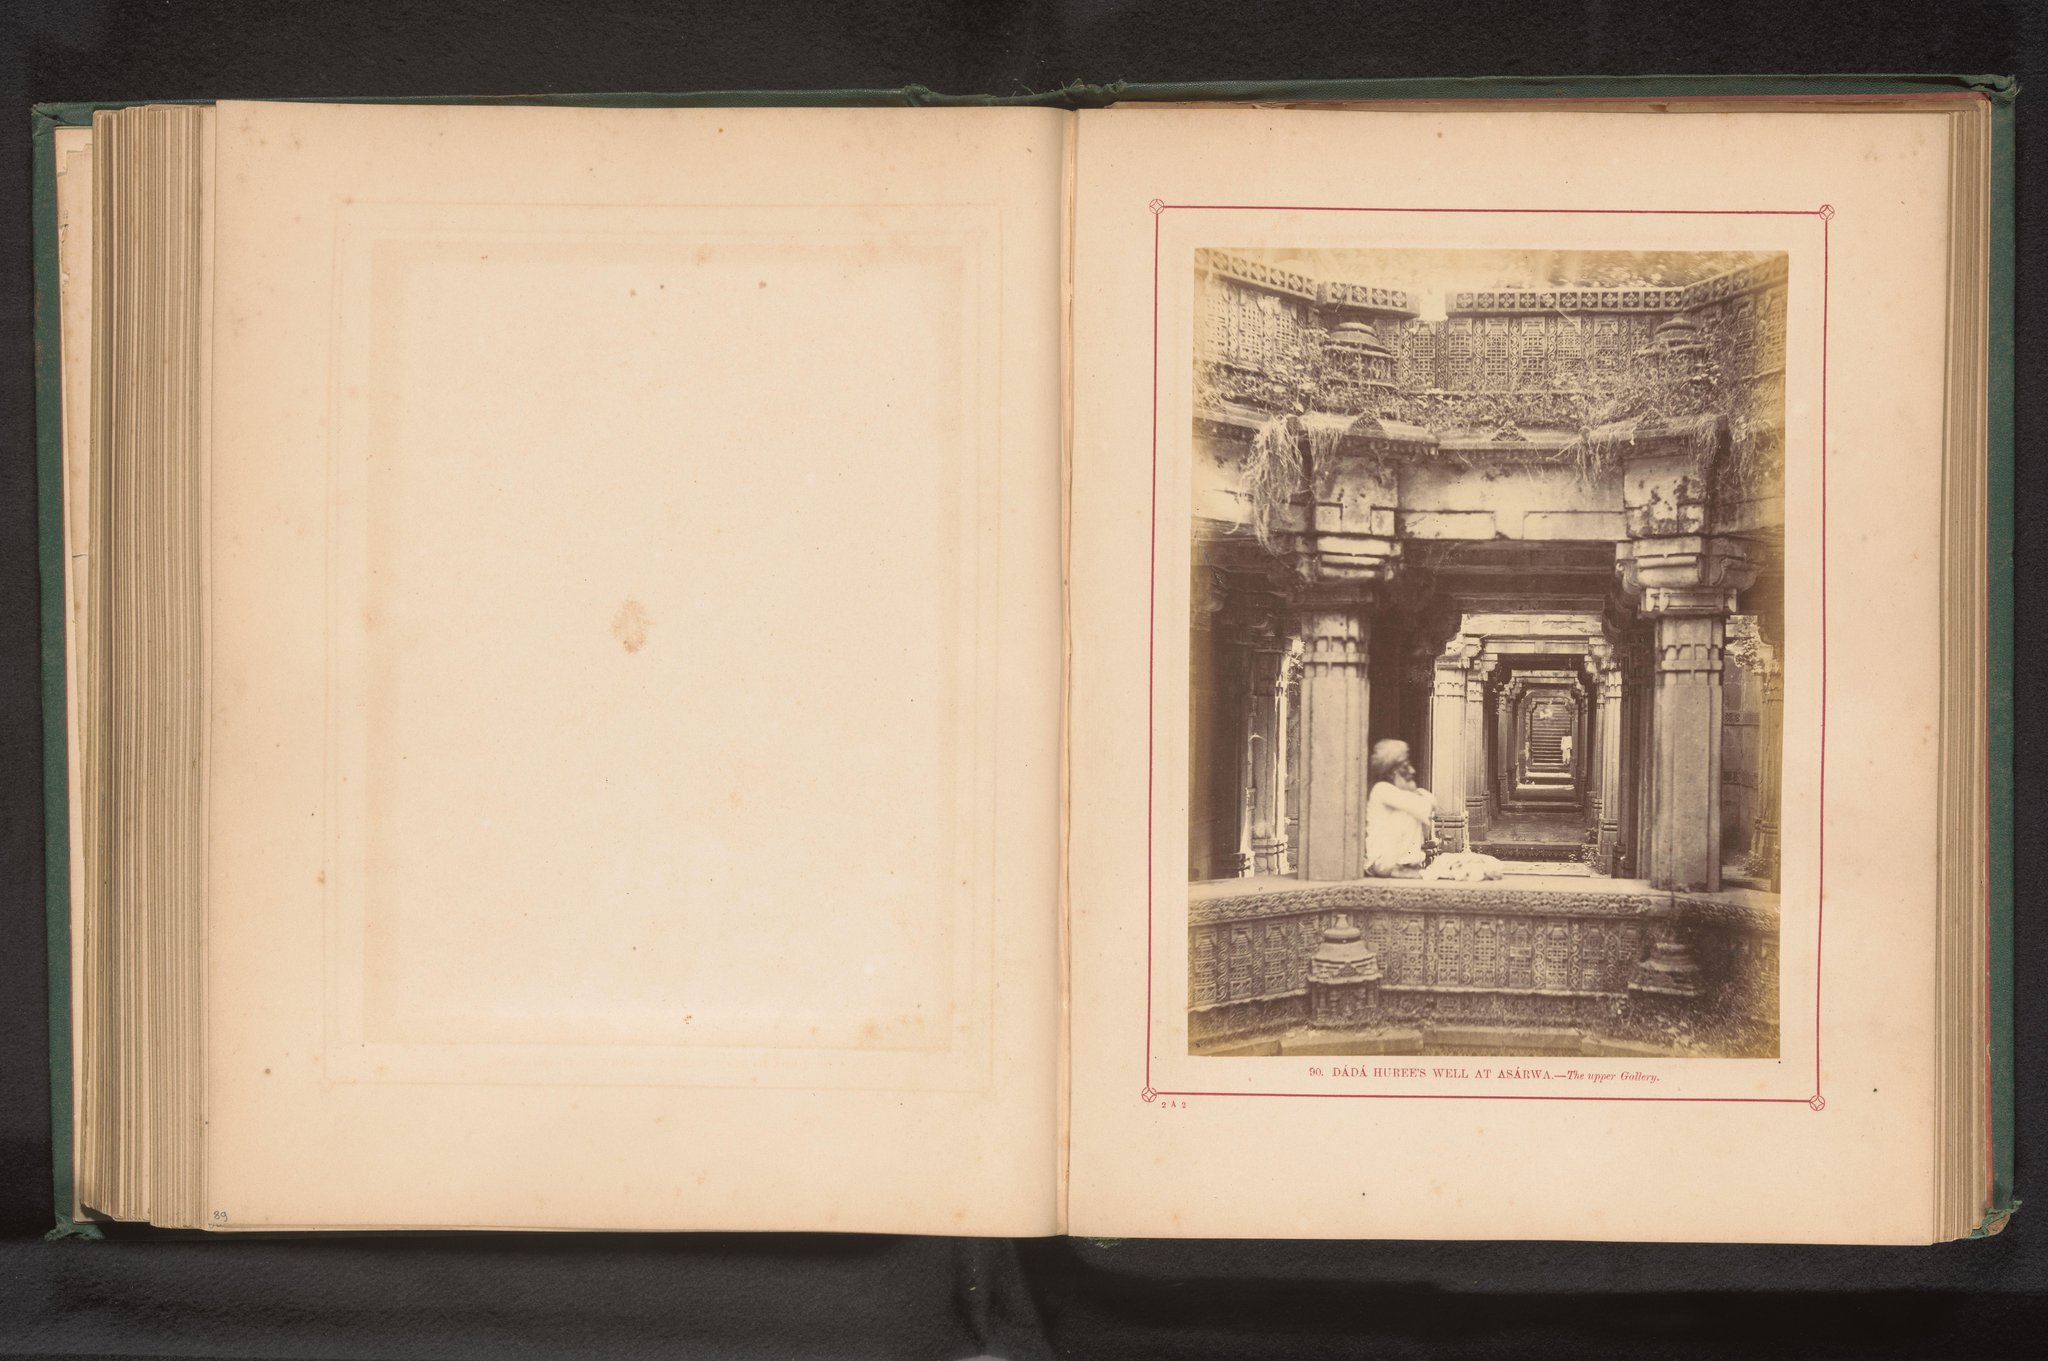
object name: photograph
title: Interieur van de Dada Harirbron in Ahmedabad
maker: thomas biggs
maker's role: fotograaf, kapitein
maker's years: 1822-1905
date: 1856-1866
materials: photographic support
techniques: albumen print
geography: ahmedabad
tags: well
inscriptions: inscription: ‘2A2’, number: ‘90.’